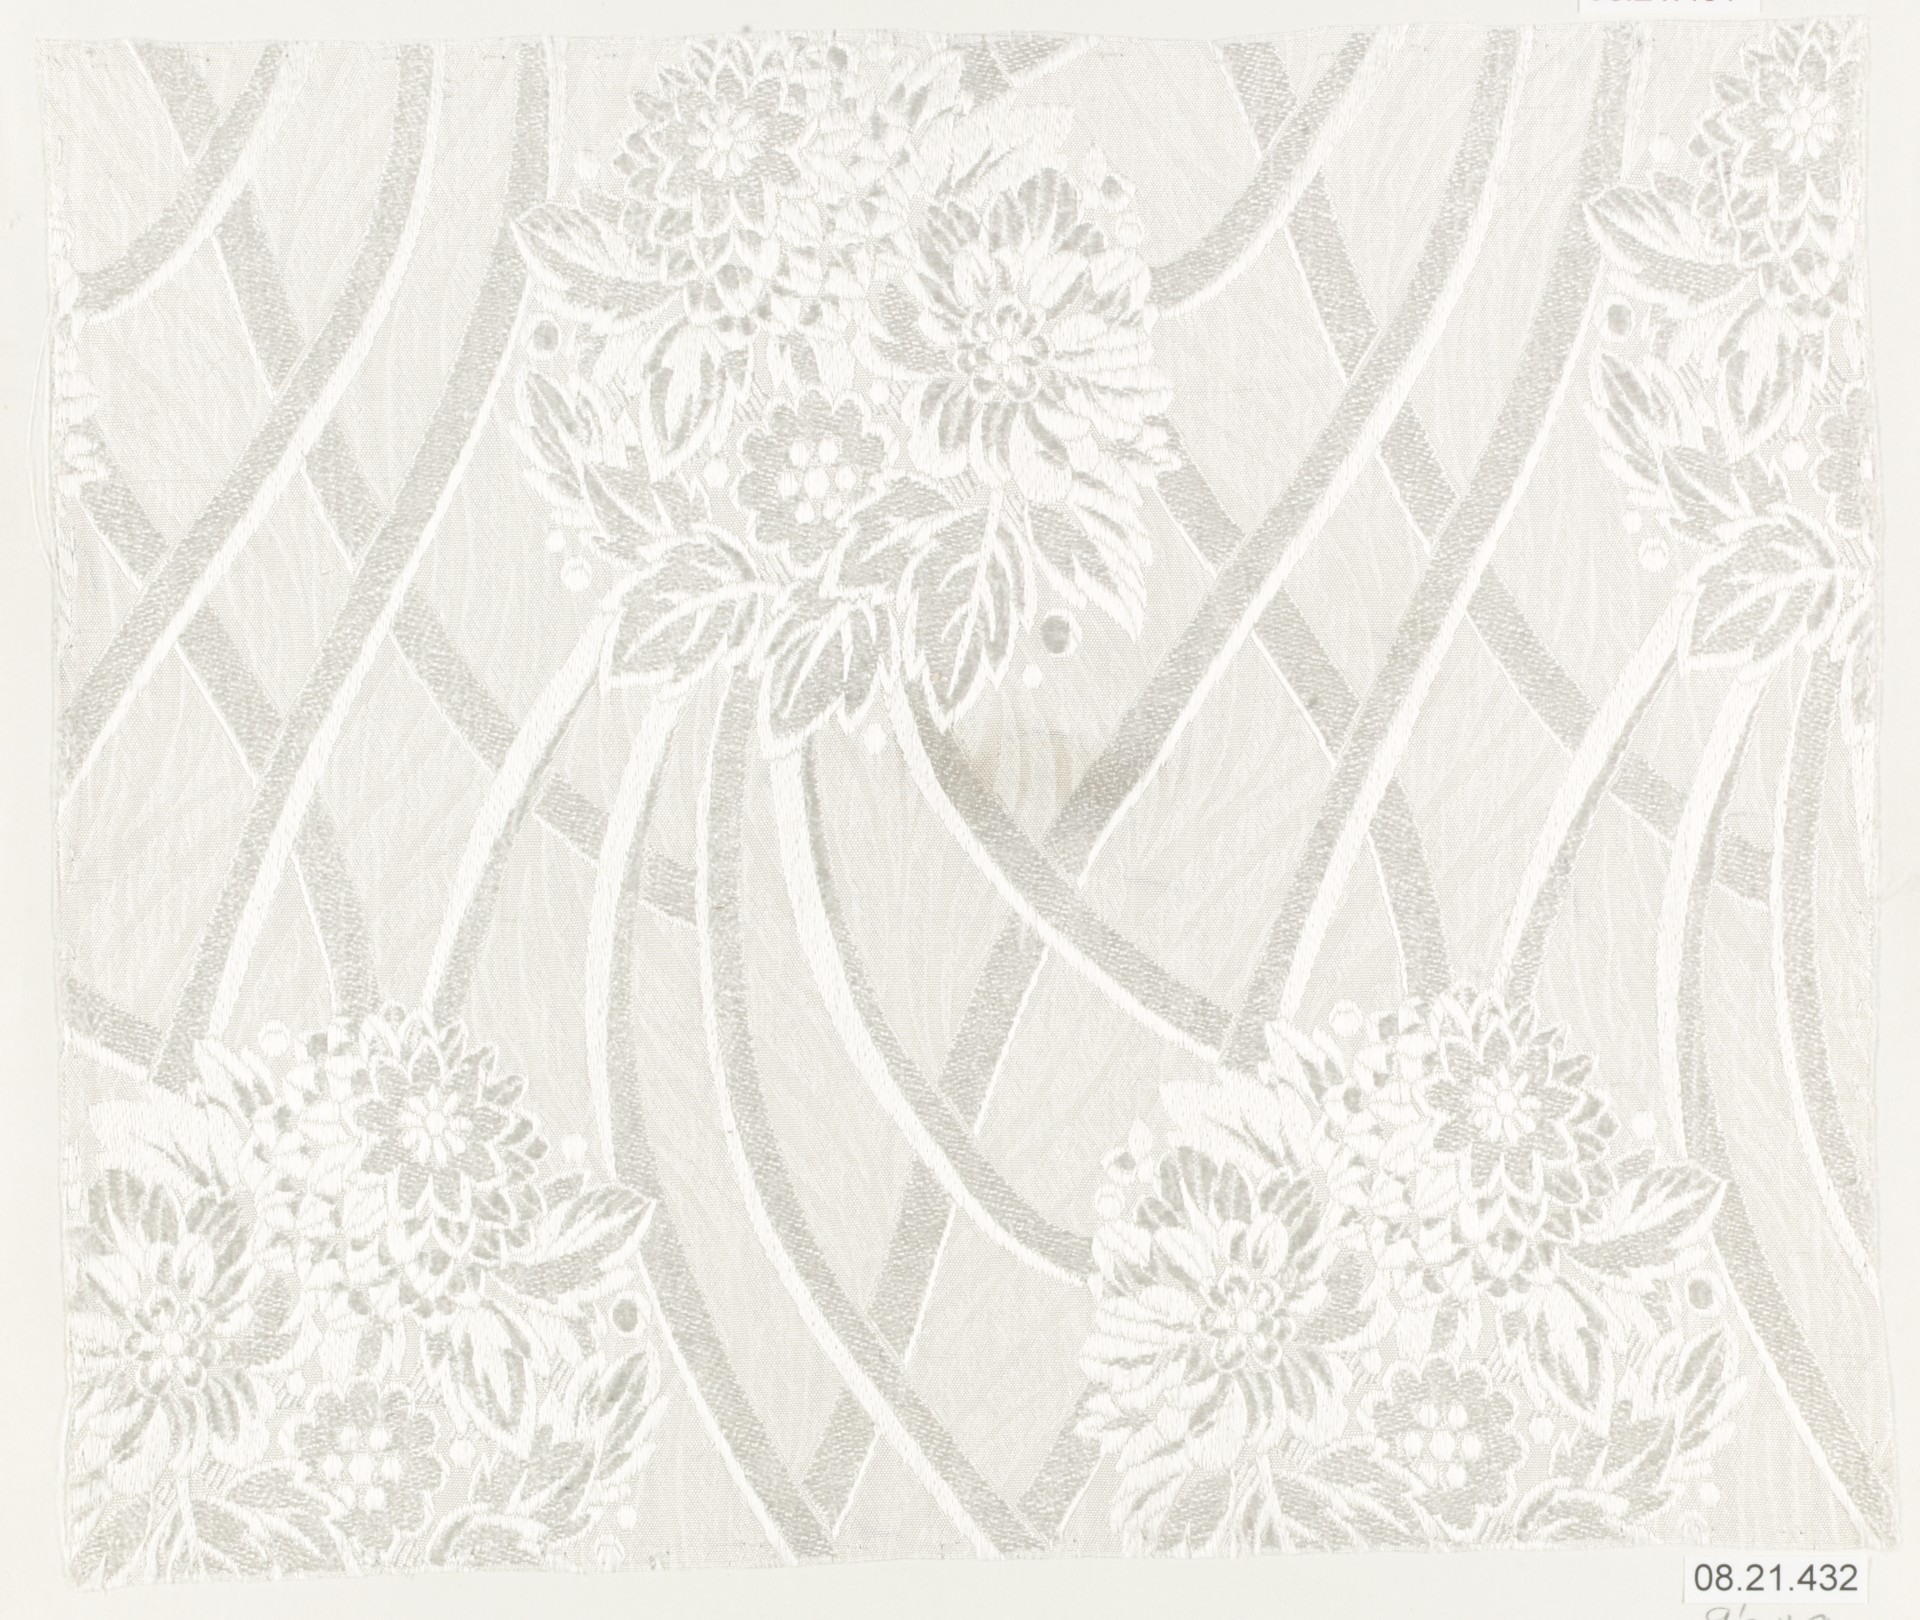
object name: textile sample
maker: Anonymous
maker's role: designer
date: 1900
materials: silk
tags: flowers